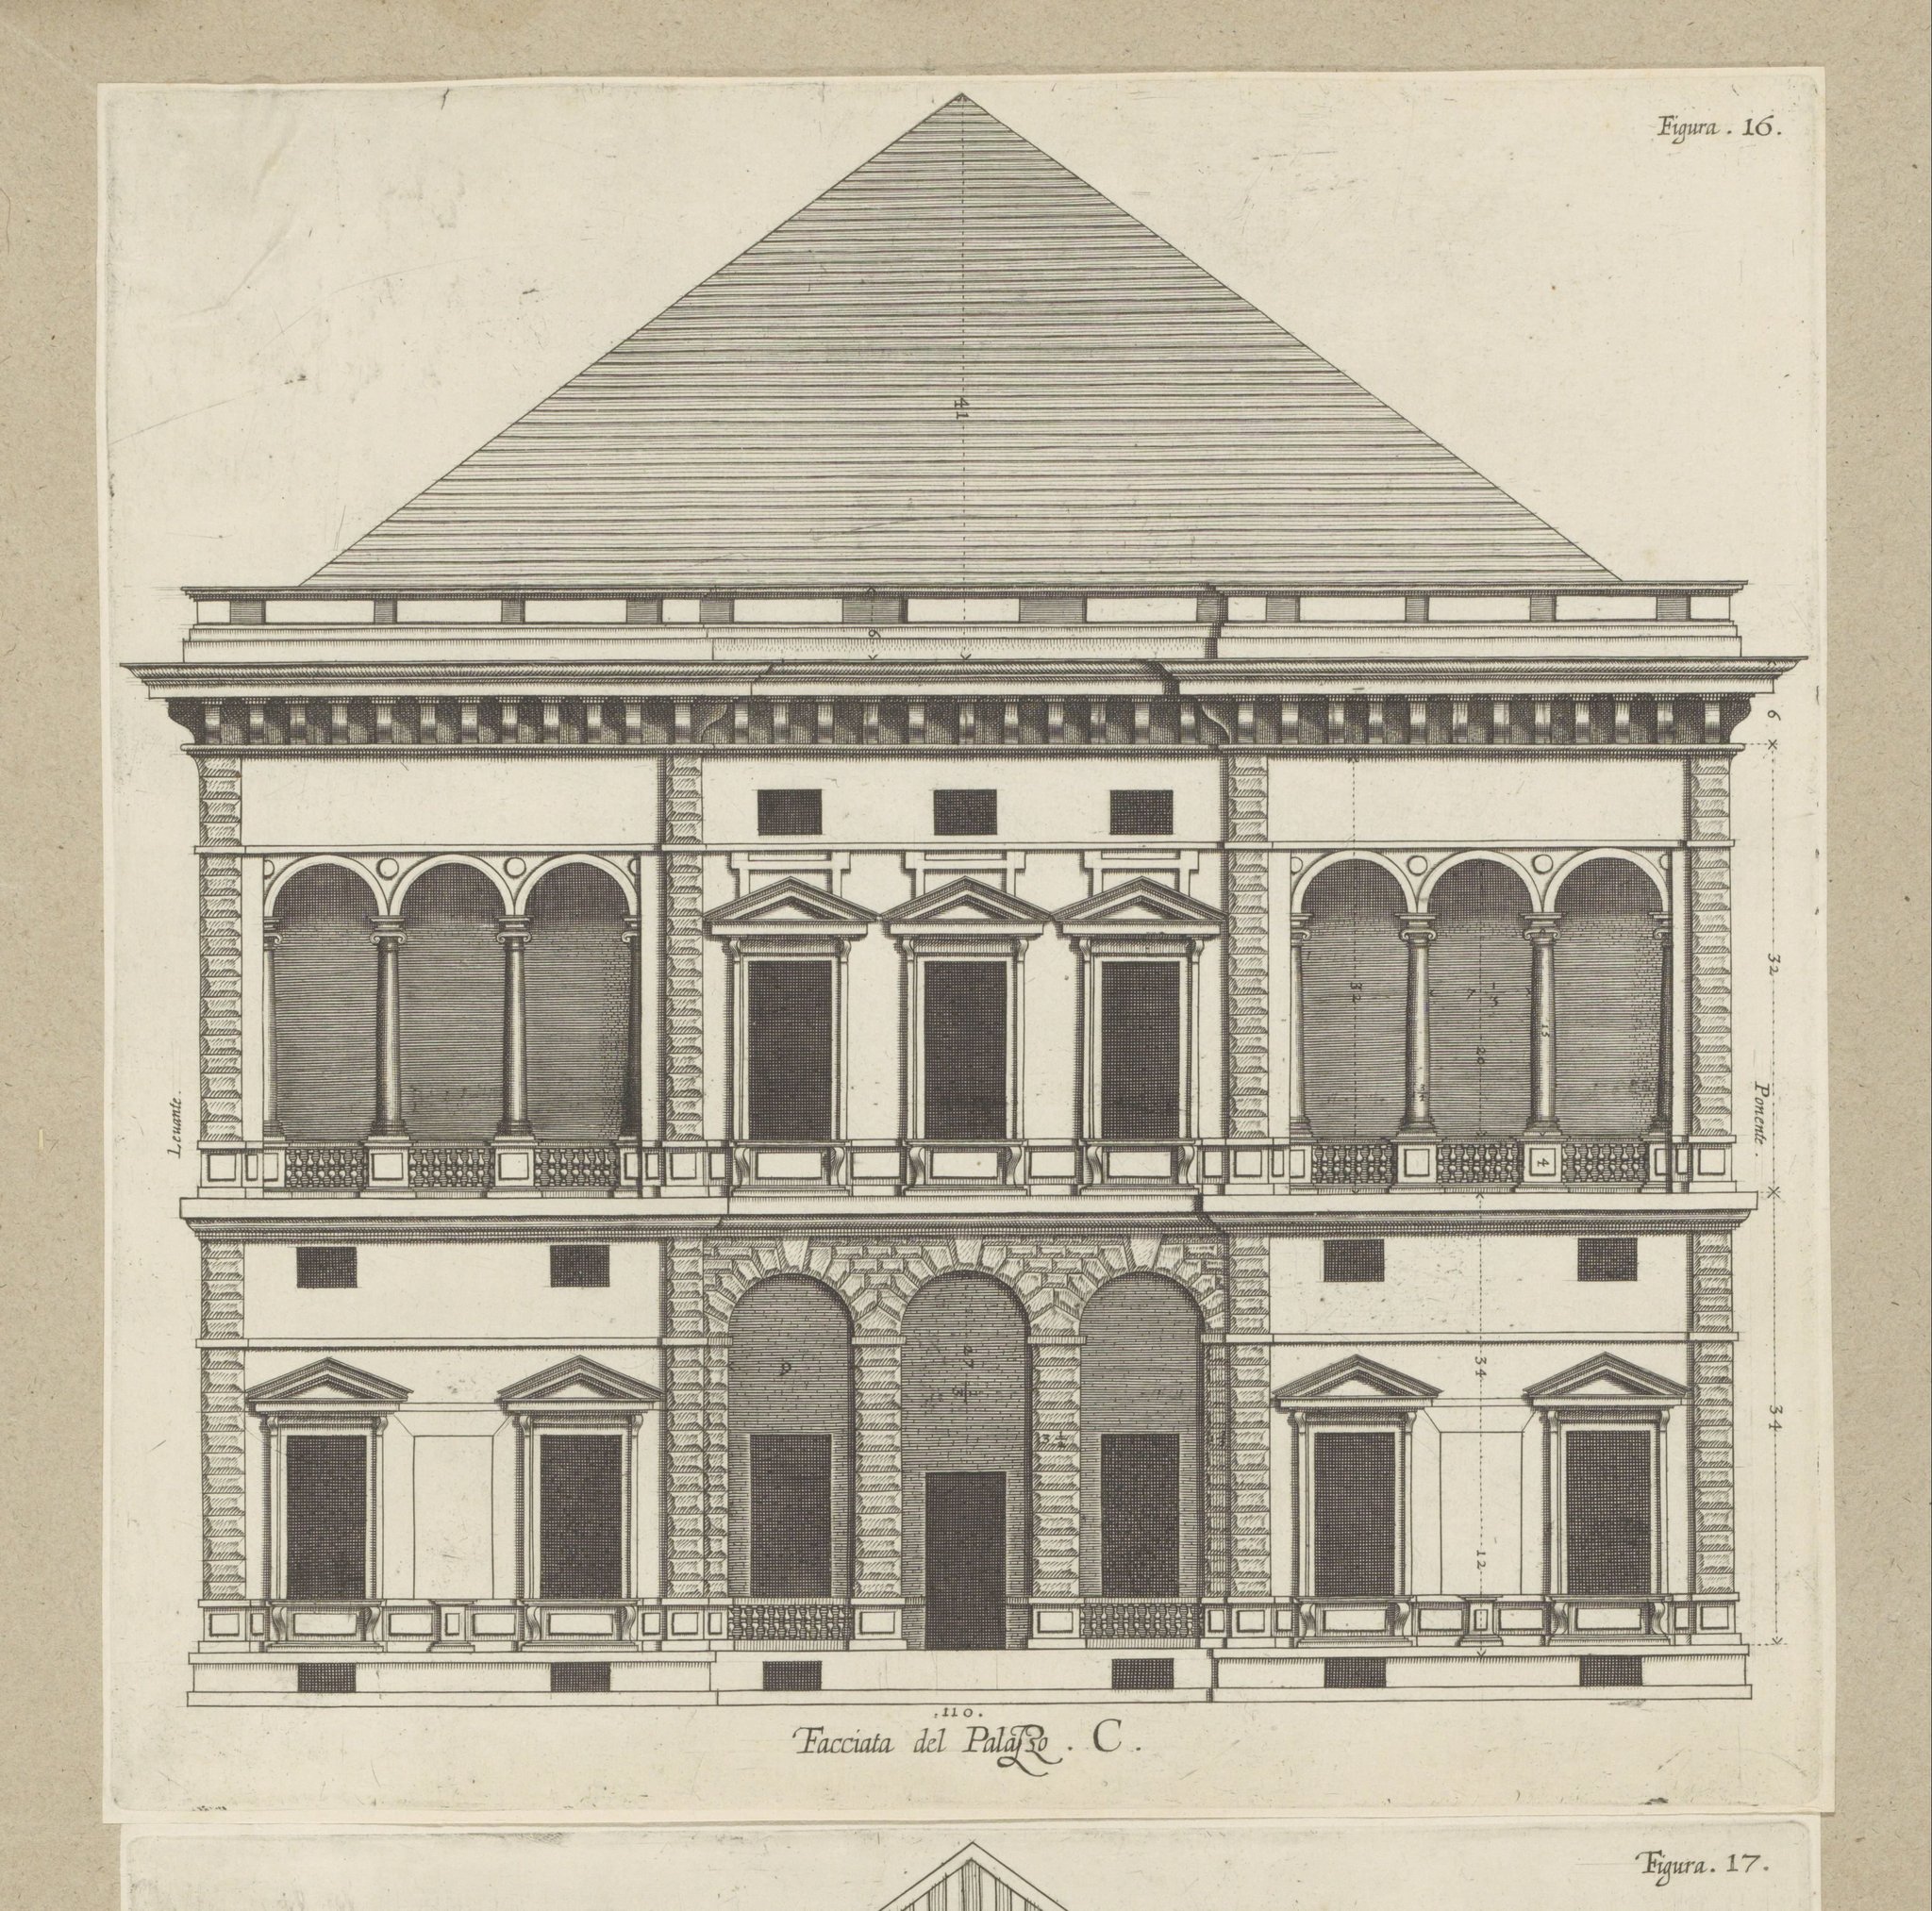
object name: album leaf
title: Opstand van de façade van de Villa Spinola di San Pietro te Genua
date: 1622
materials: paper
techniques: engraving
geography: antwerp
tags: hôtel, i.e. small palace in city, exterior ~ architectural design or model, front façade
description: Deze prent maakt deel uit van een album.